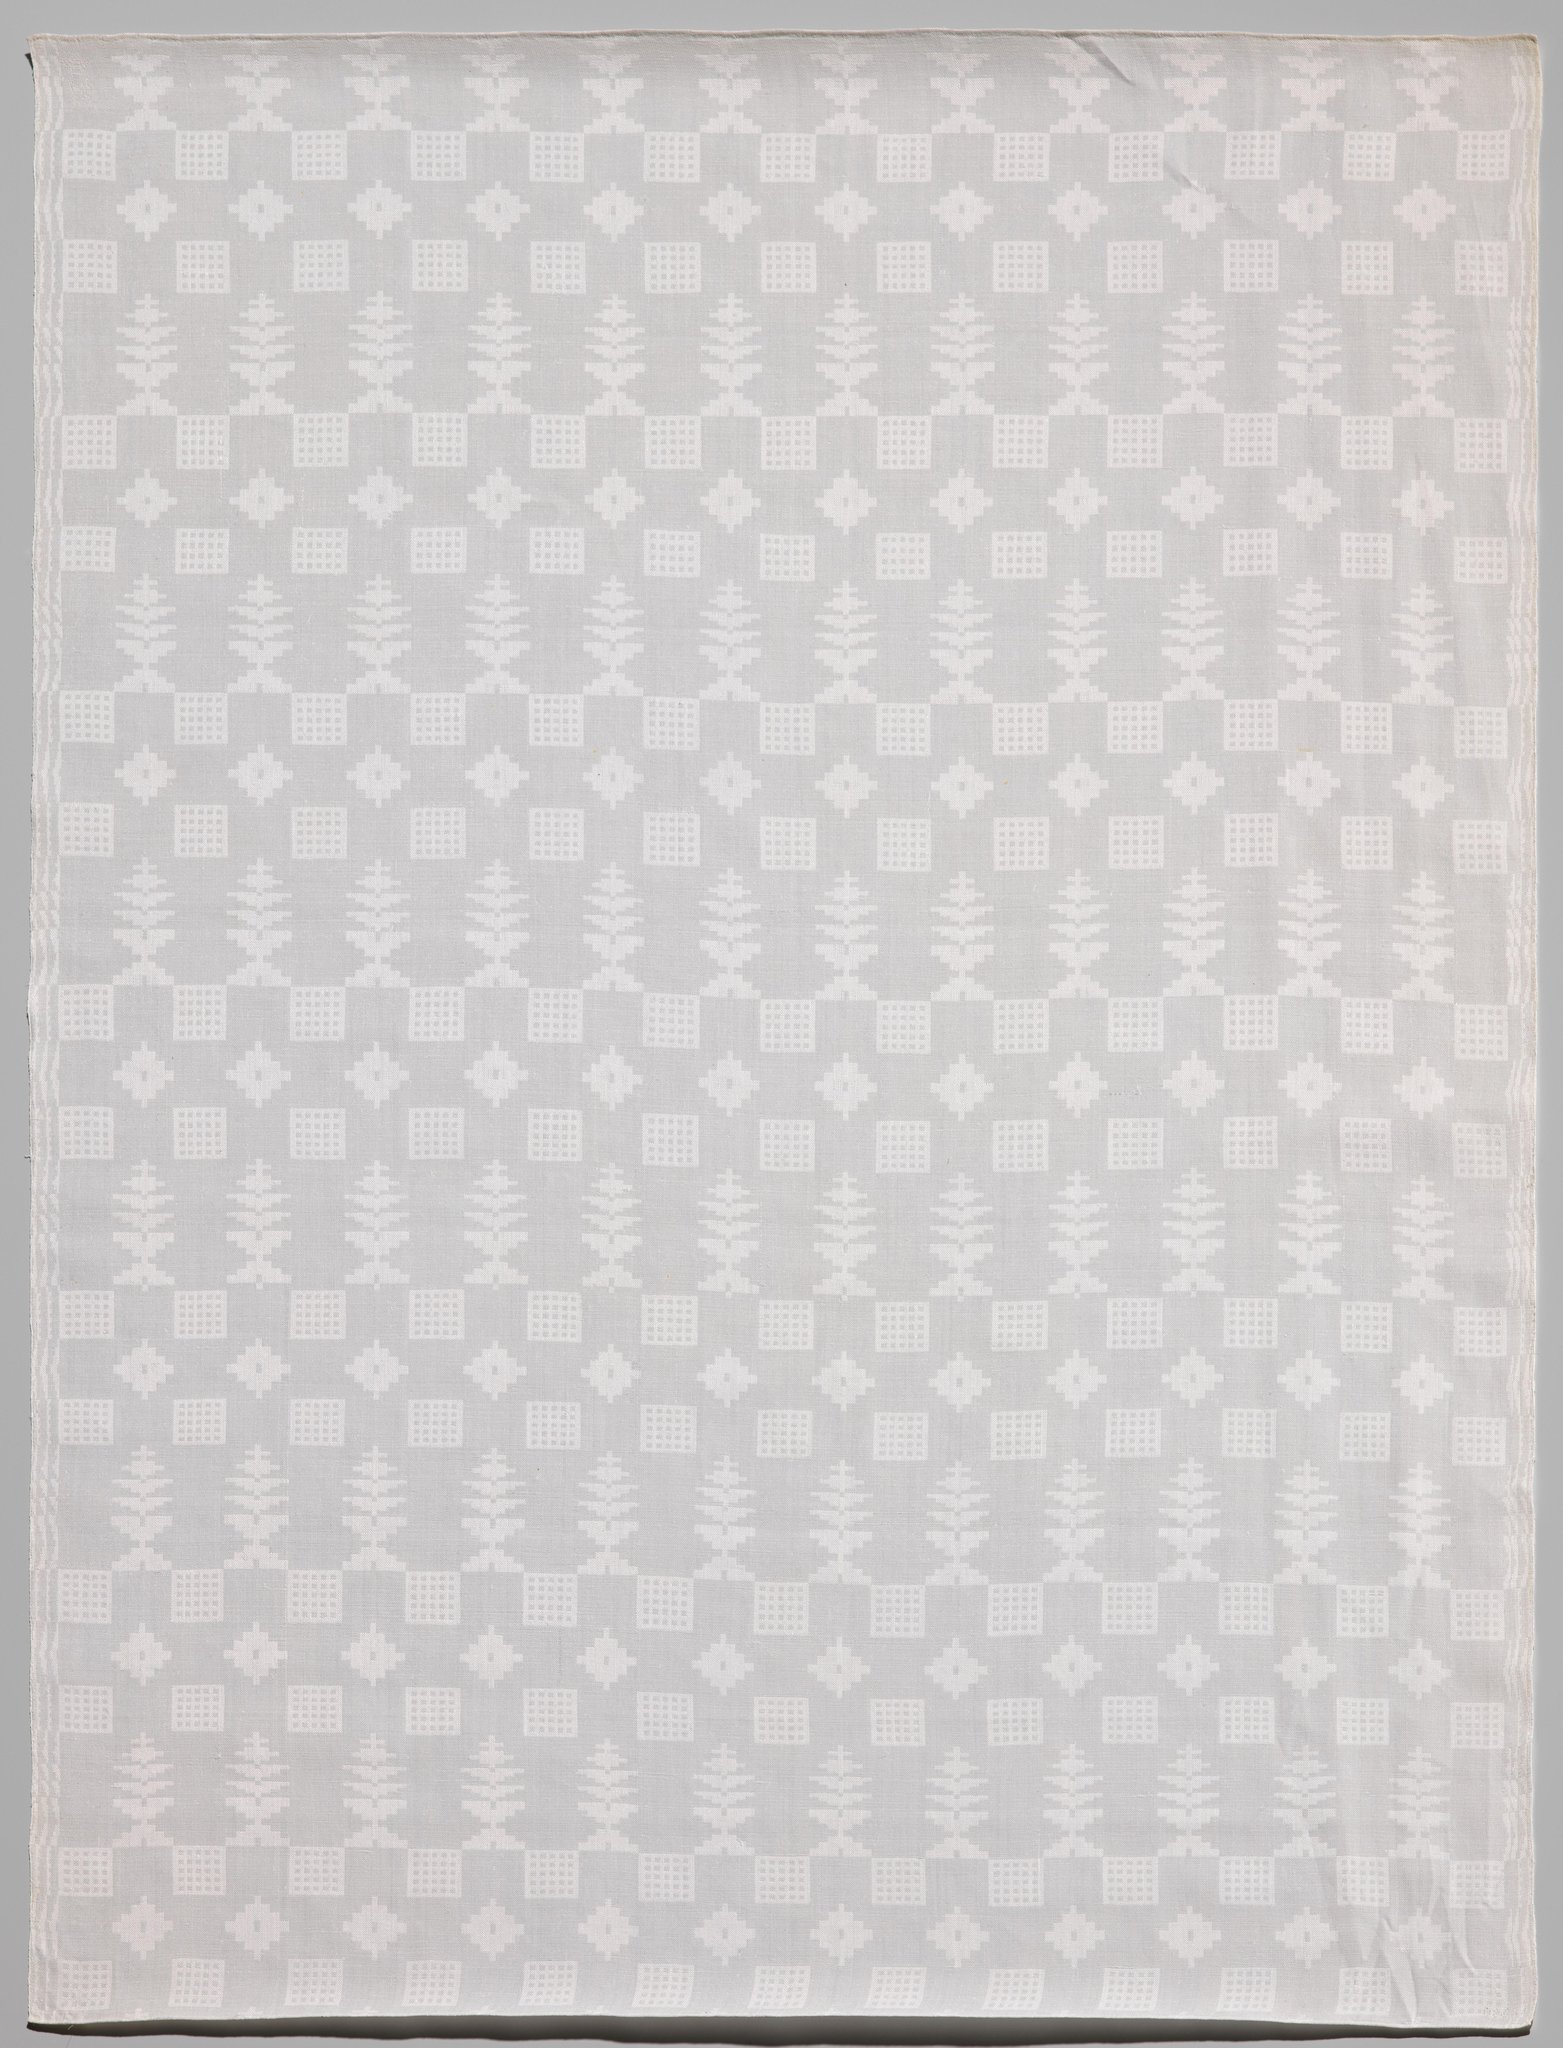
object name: napkin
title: Servet van linnen met pellenpatroon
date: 1730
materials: linen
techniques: twill, peeled fabric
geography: northern netherlands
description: wit linnen servet met pellen patroon, merk kroon WG 42 en 1730